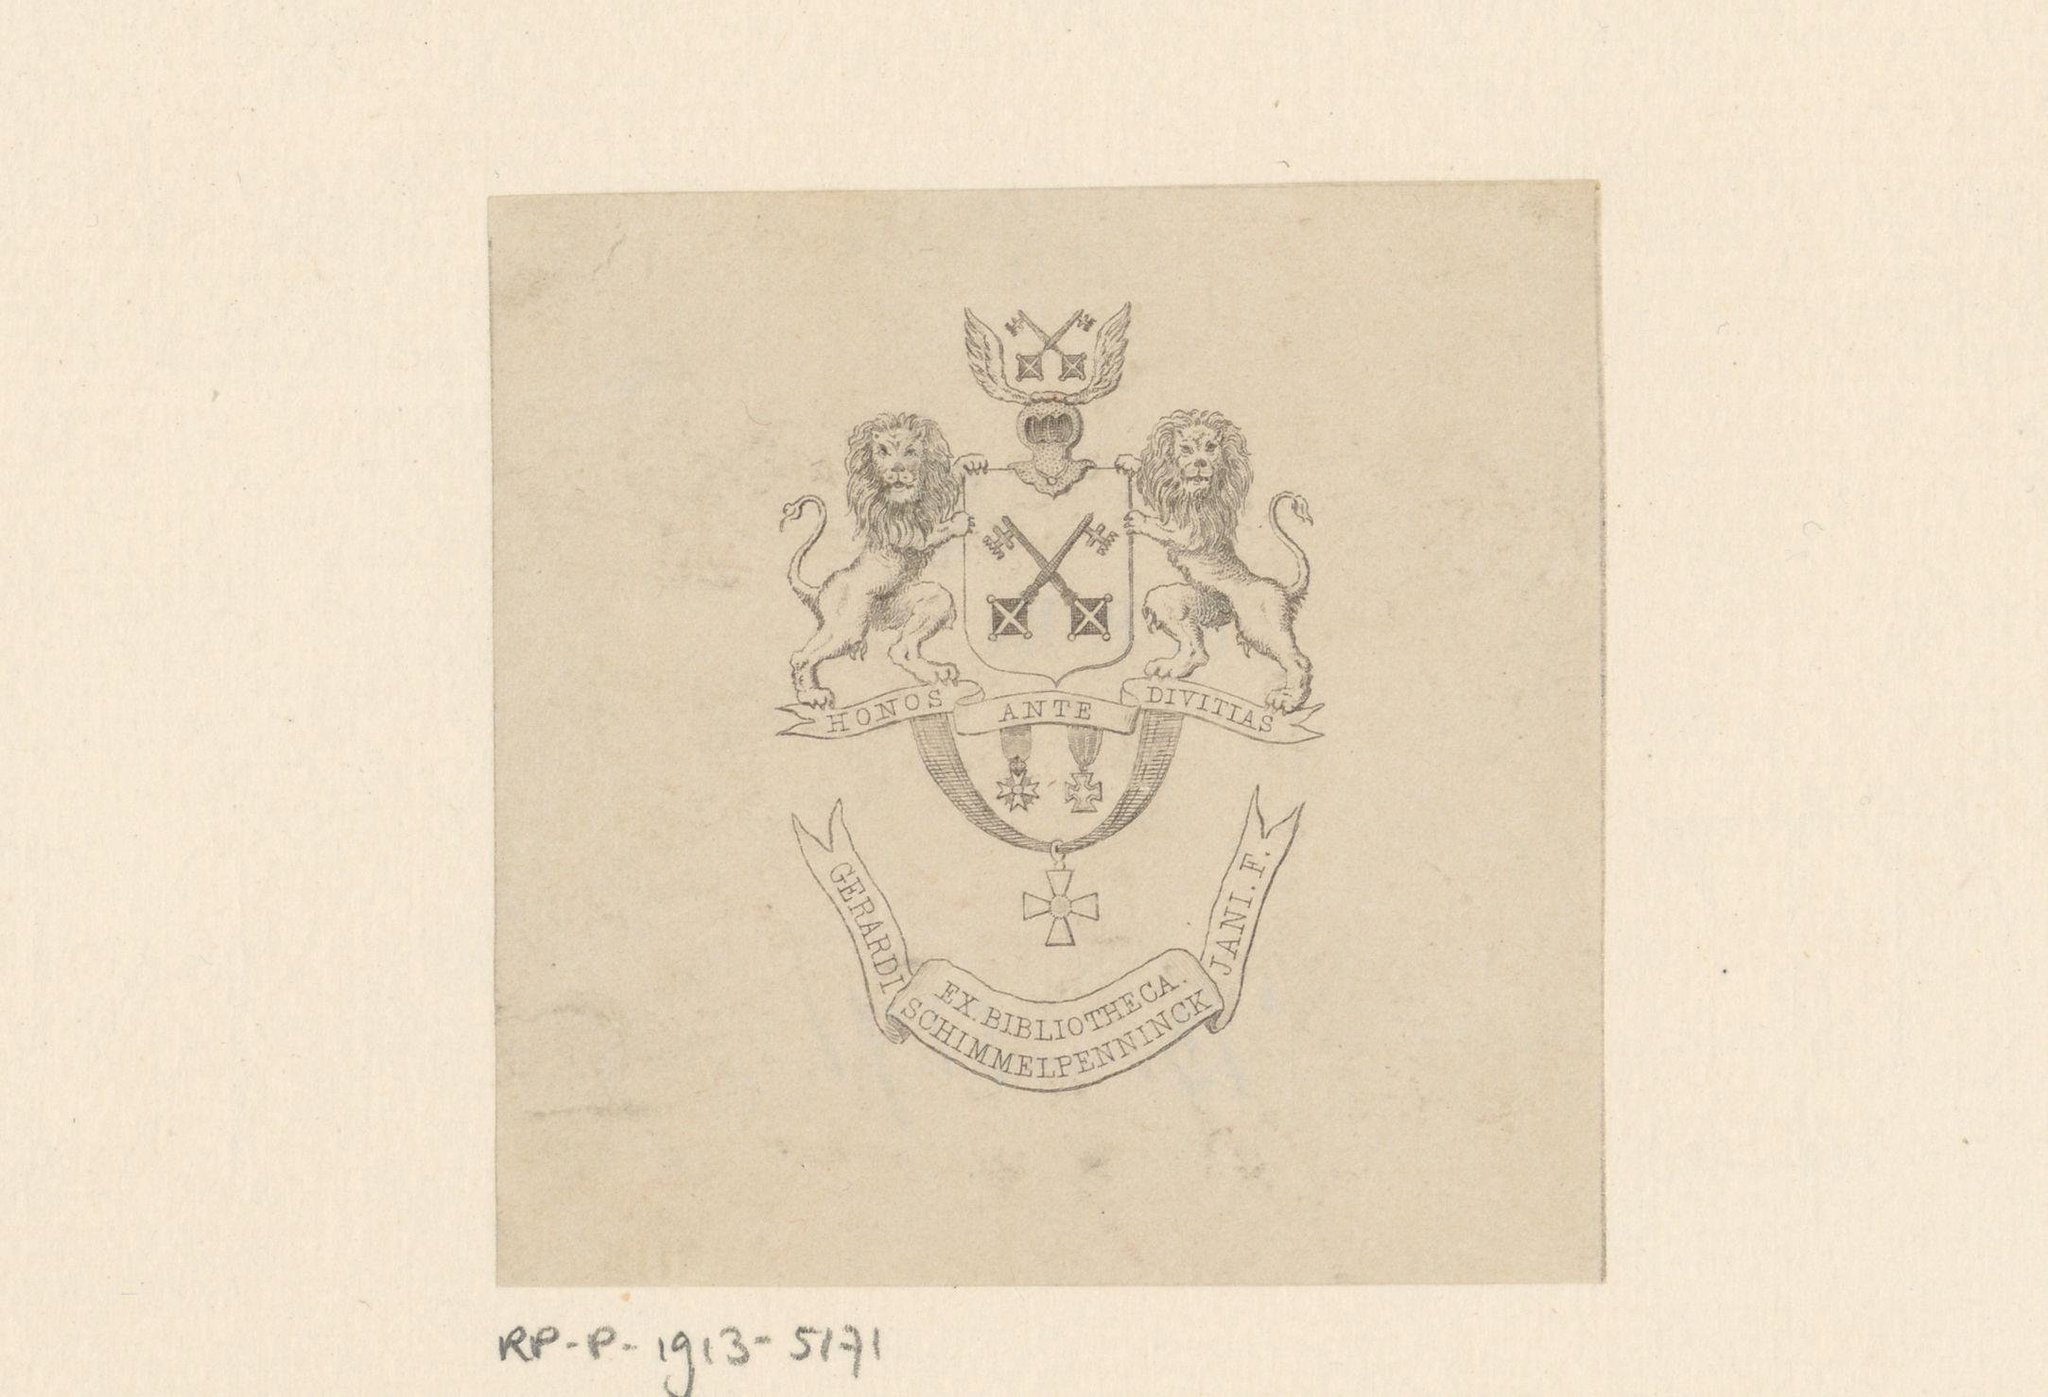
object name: bookplate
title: Ex libris van Gerrit graaf Schimmelpenninck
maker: Anonymous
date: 1804-1863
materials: paper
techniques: engraving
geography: netherlands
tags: amsterdam, arnhem, beasts of prey, predatory animals: lion, armorial bearing, heraldry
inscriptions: collector's mark: Lugt 2233, collector's mark: Lugt 2760